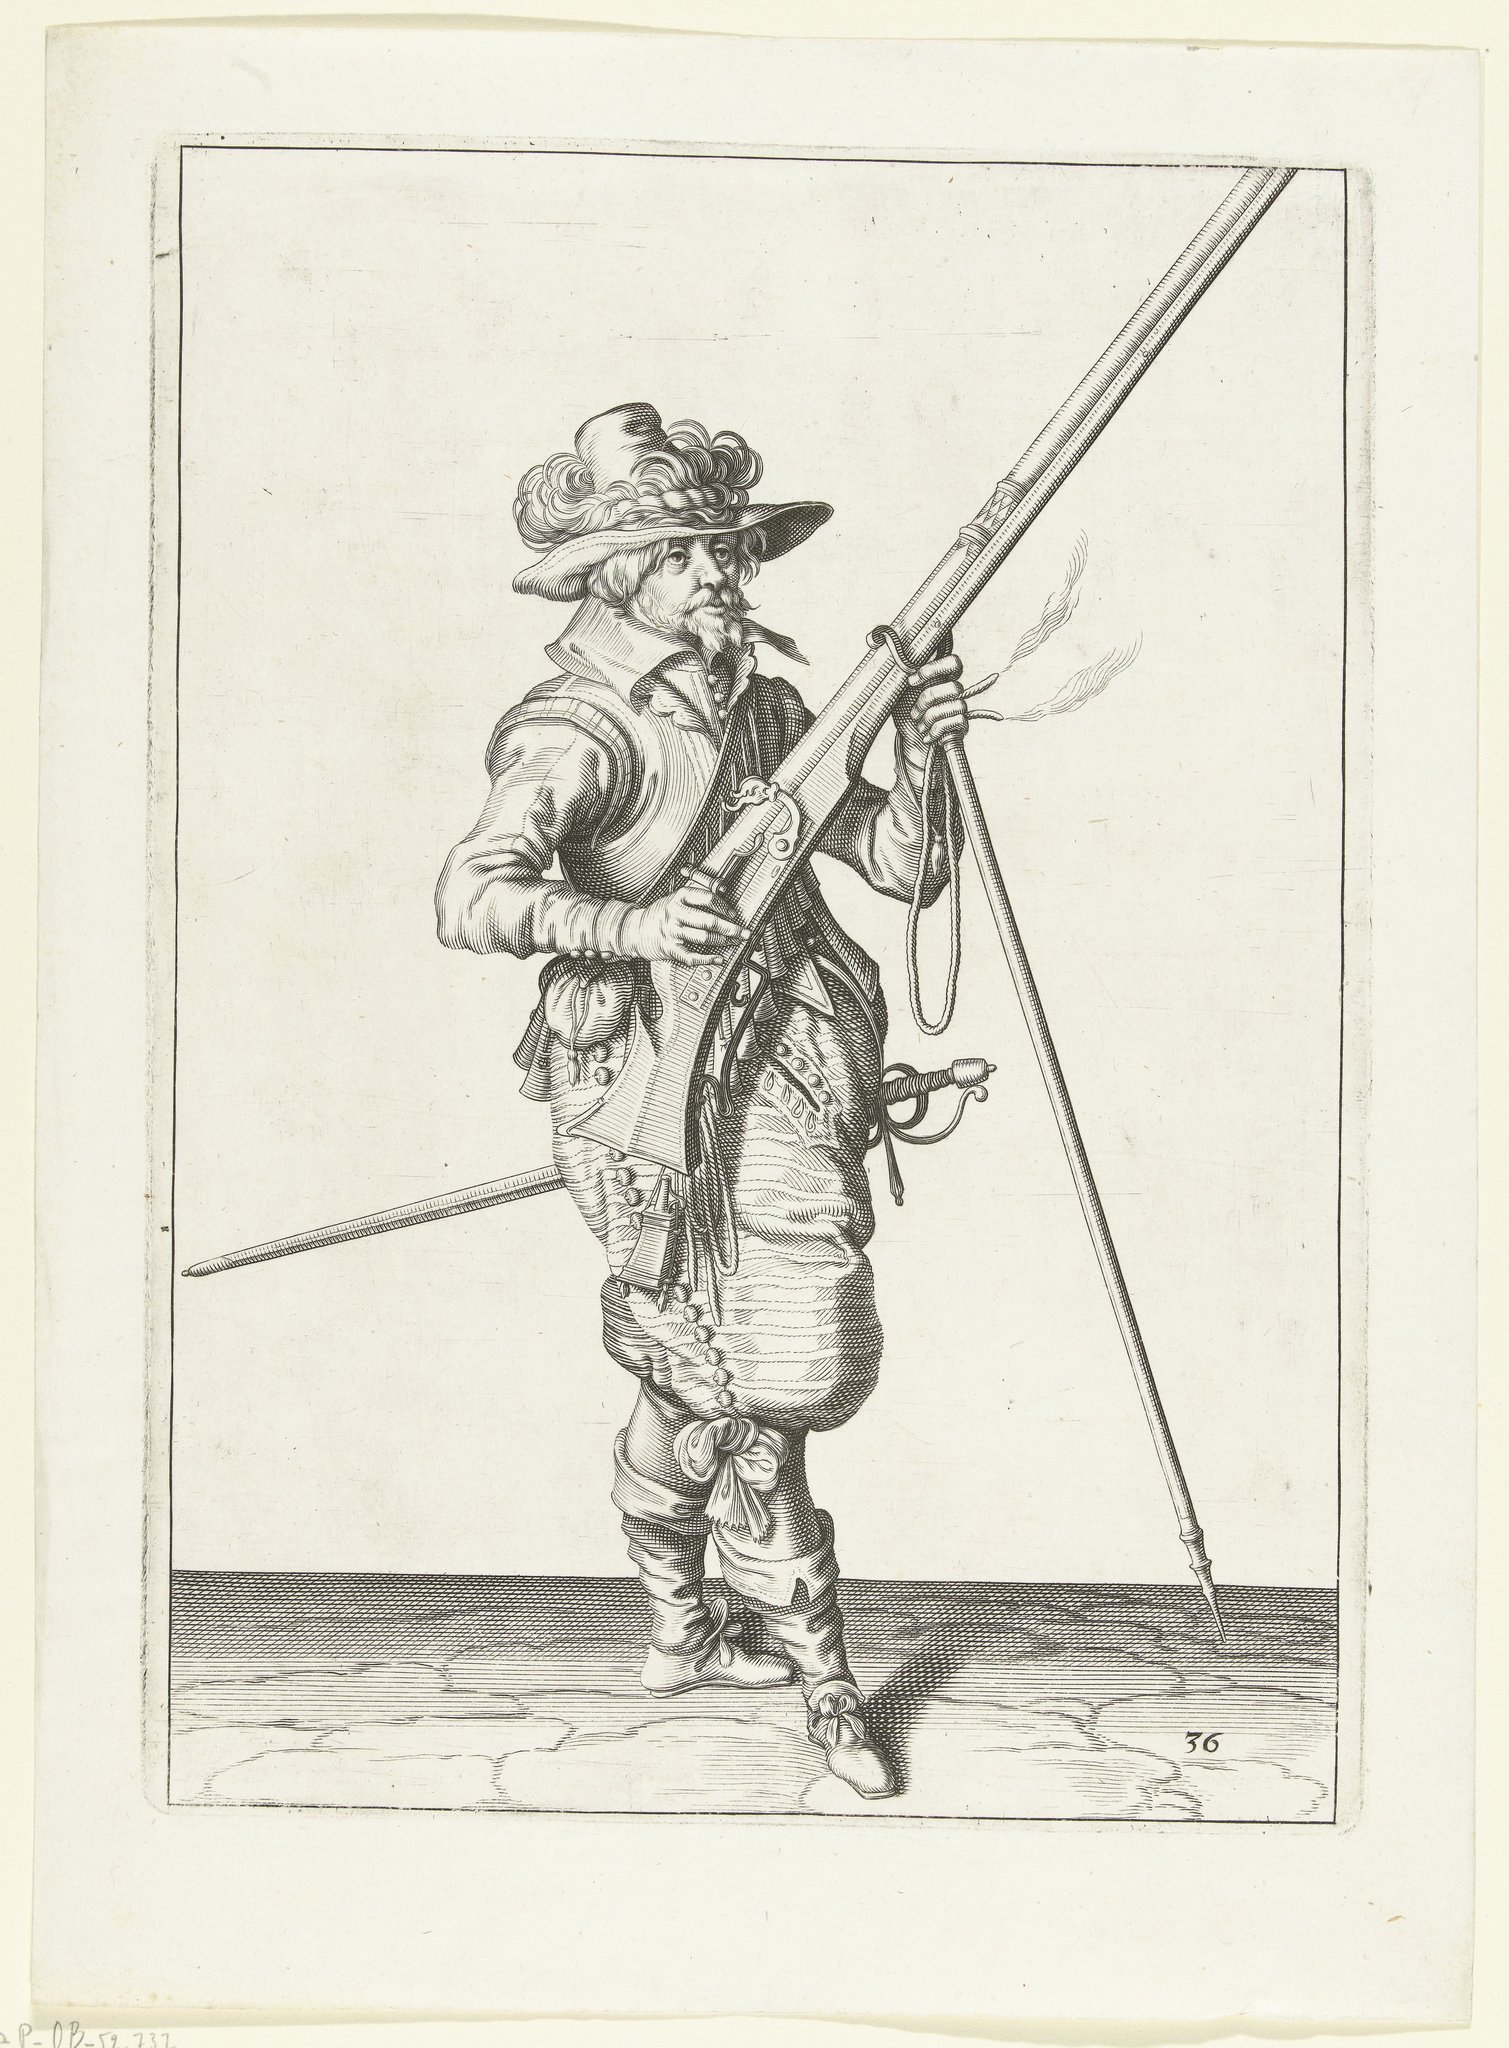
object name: print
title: Soldaat op wacht die zijn musket met zijn rechterhand schuin omhoog gericht vasthoudt, terwijl hij de loop met zijn linkerhand op zijn furket plaatst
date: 1597-1607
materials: paper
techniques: engraving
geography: netherlands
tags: manoeuvre ~ military training, firearms: rifle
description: Een soldaat op wacht, ten voeten uit, naar rechts, die een musket (een bepaald type vuurwapen) met zijn rechterhand vasthoudt, de loop schuin omhoog gericht. Hij plaatst de loop met zijn linkerhand, waarin ook een brandende lont, op zijn furket (musketvork). Deze prent is onderdeel van de reeks van 43 genummerde prenten van musketiers uit de Wapenhandelinghe.